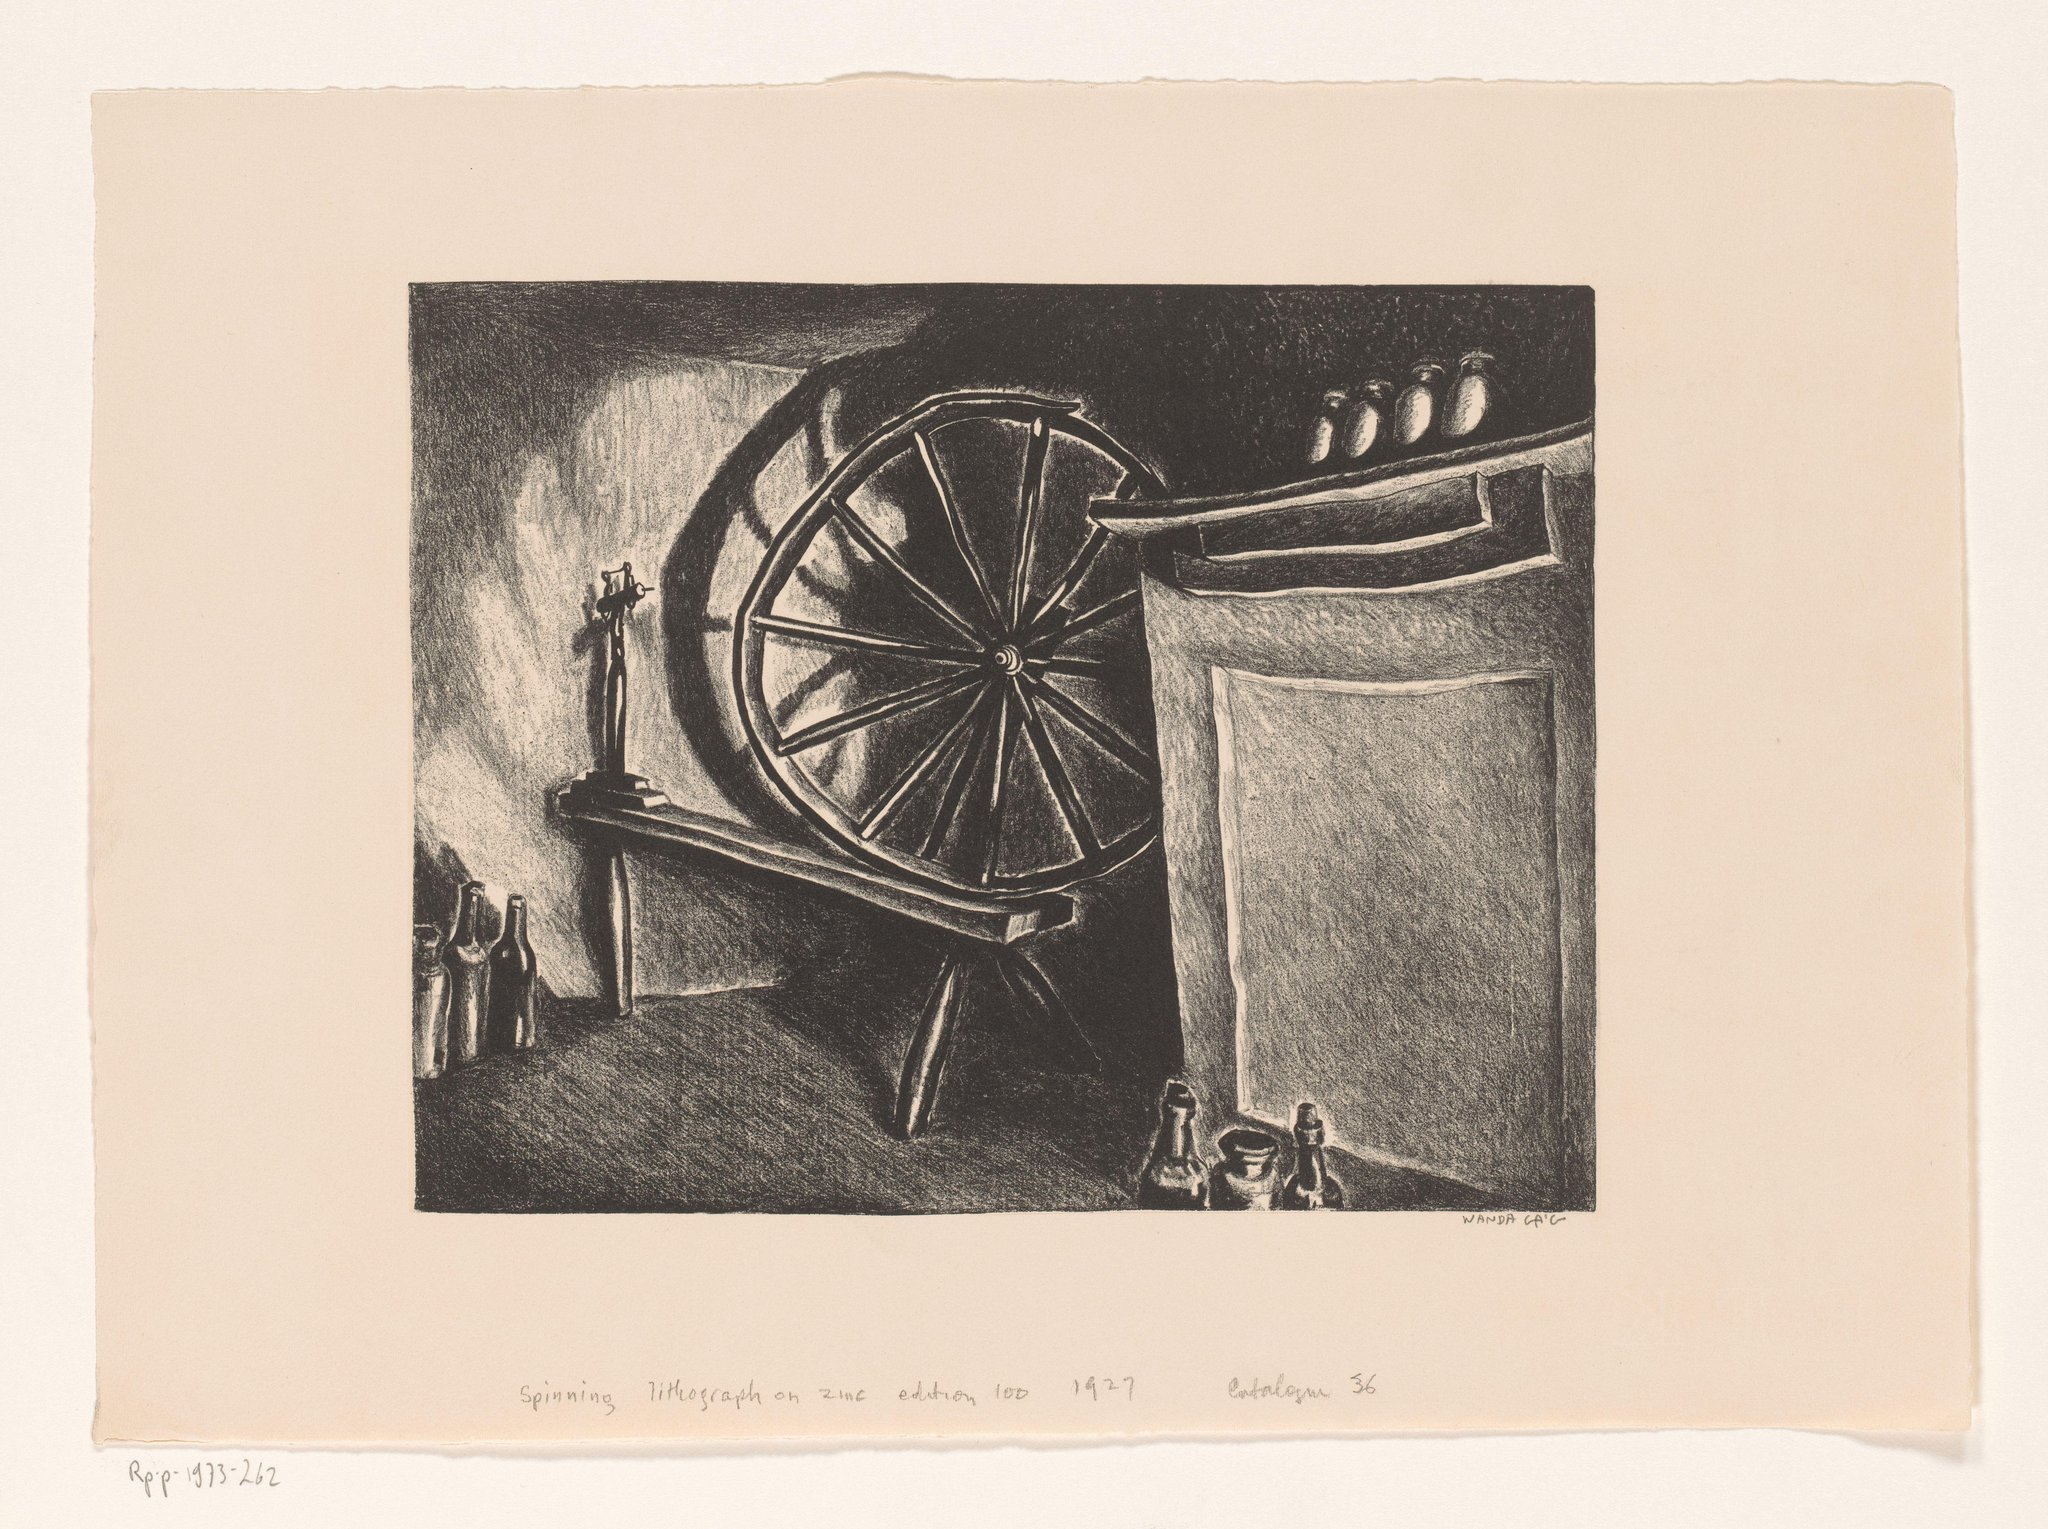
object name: print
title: Spinnewiel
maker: wanda gág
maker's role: print maker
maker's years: 1893-1946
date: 1903-1946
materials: paper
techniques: lithograph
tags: spinning-wheel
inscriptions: collector's mark: Lugt 2228